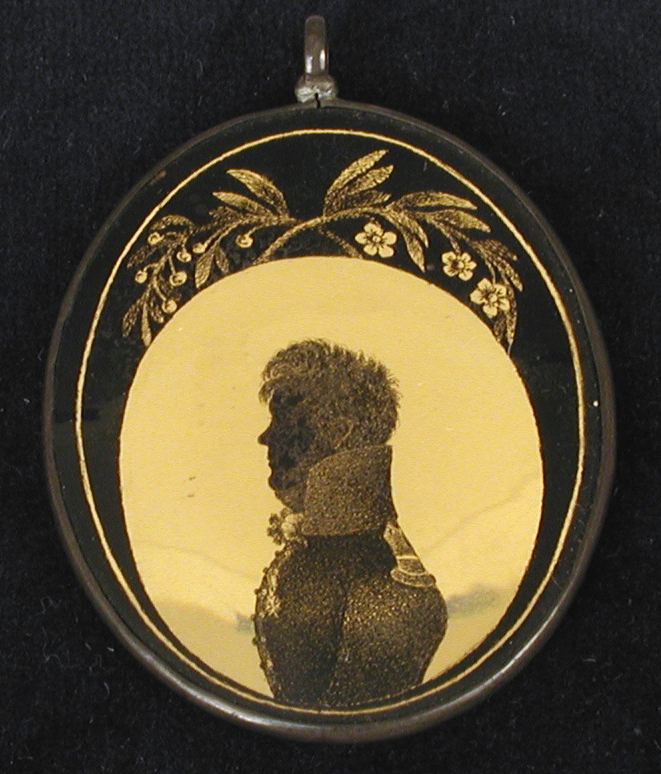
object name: pendant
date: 1801-1900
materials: glass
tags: men,profiles,flowers,leaves